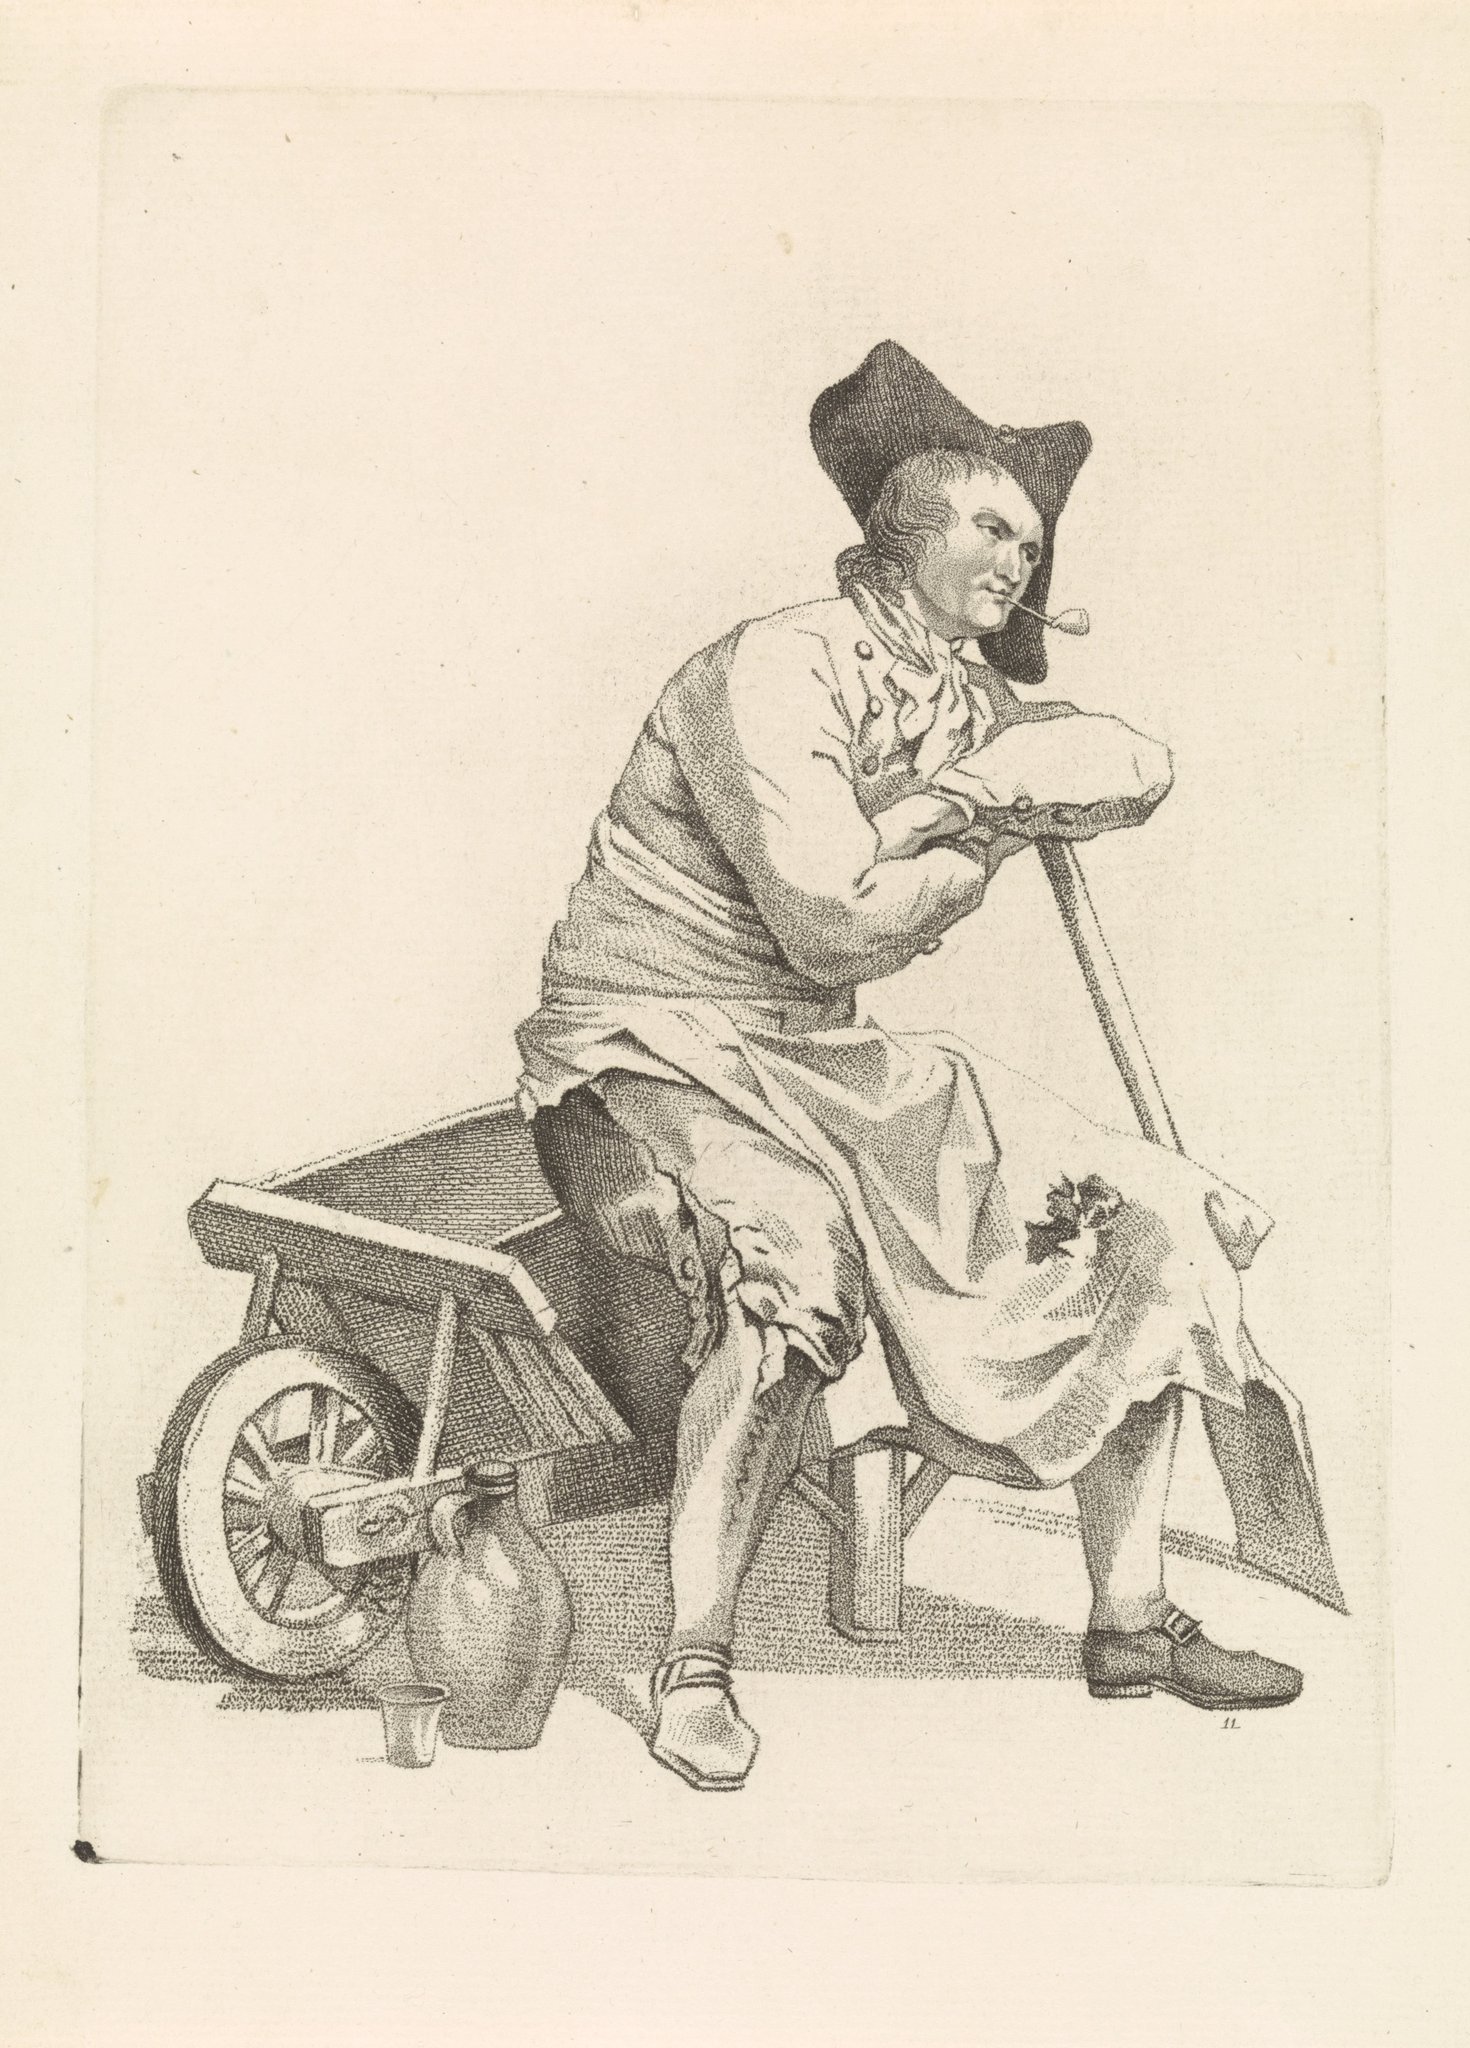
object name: print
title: Man zittend op de rand van een kruiwagen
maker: mathias de sallieth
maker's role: print maker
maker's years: 1749-1791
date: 1772-1791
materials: paper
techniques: printmaking, etching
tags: adult man, head-gear: hat (+ men's clothes), agricultural implements: spade, wheelbarrow, resting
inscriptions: collector's mark: Lugt 2228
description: De prent verscheen vanaf 1818 tevens als onderdeel van een 33-delige reeks prenten door Mathias de Sallieth, samengebonden in: Perkois, Jacobus, Prins, Johannes Huibert. Verzameling van verschillende gekleede mans- en vrouwenstanden, ter oefening van jonge schilders en liefhebbers. Rotterdam: Johannes Immerzeel, 1818.